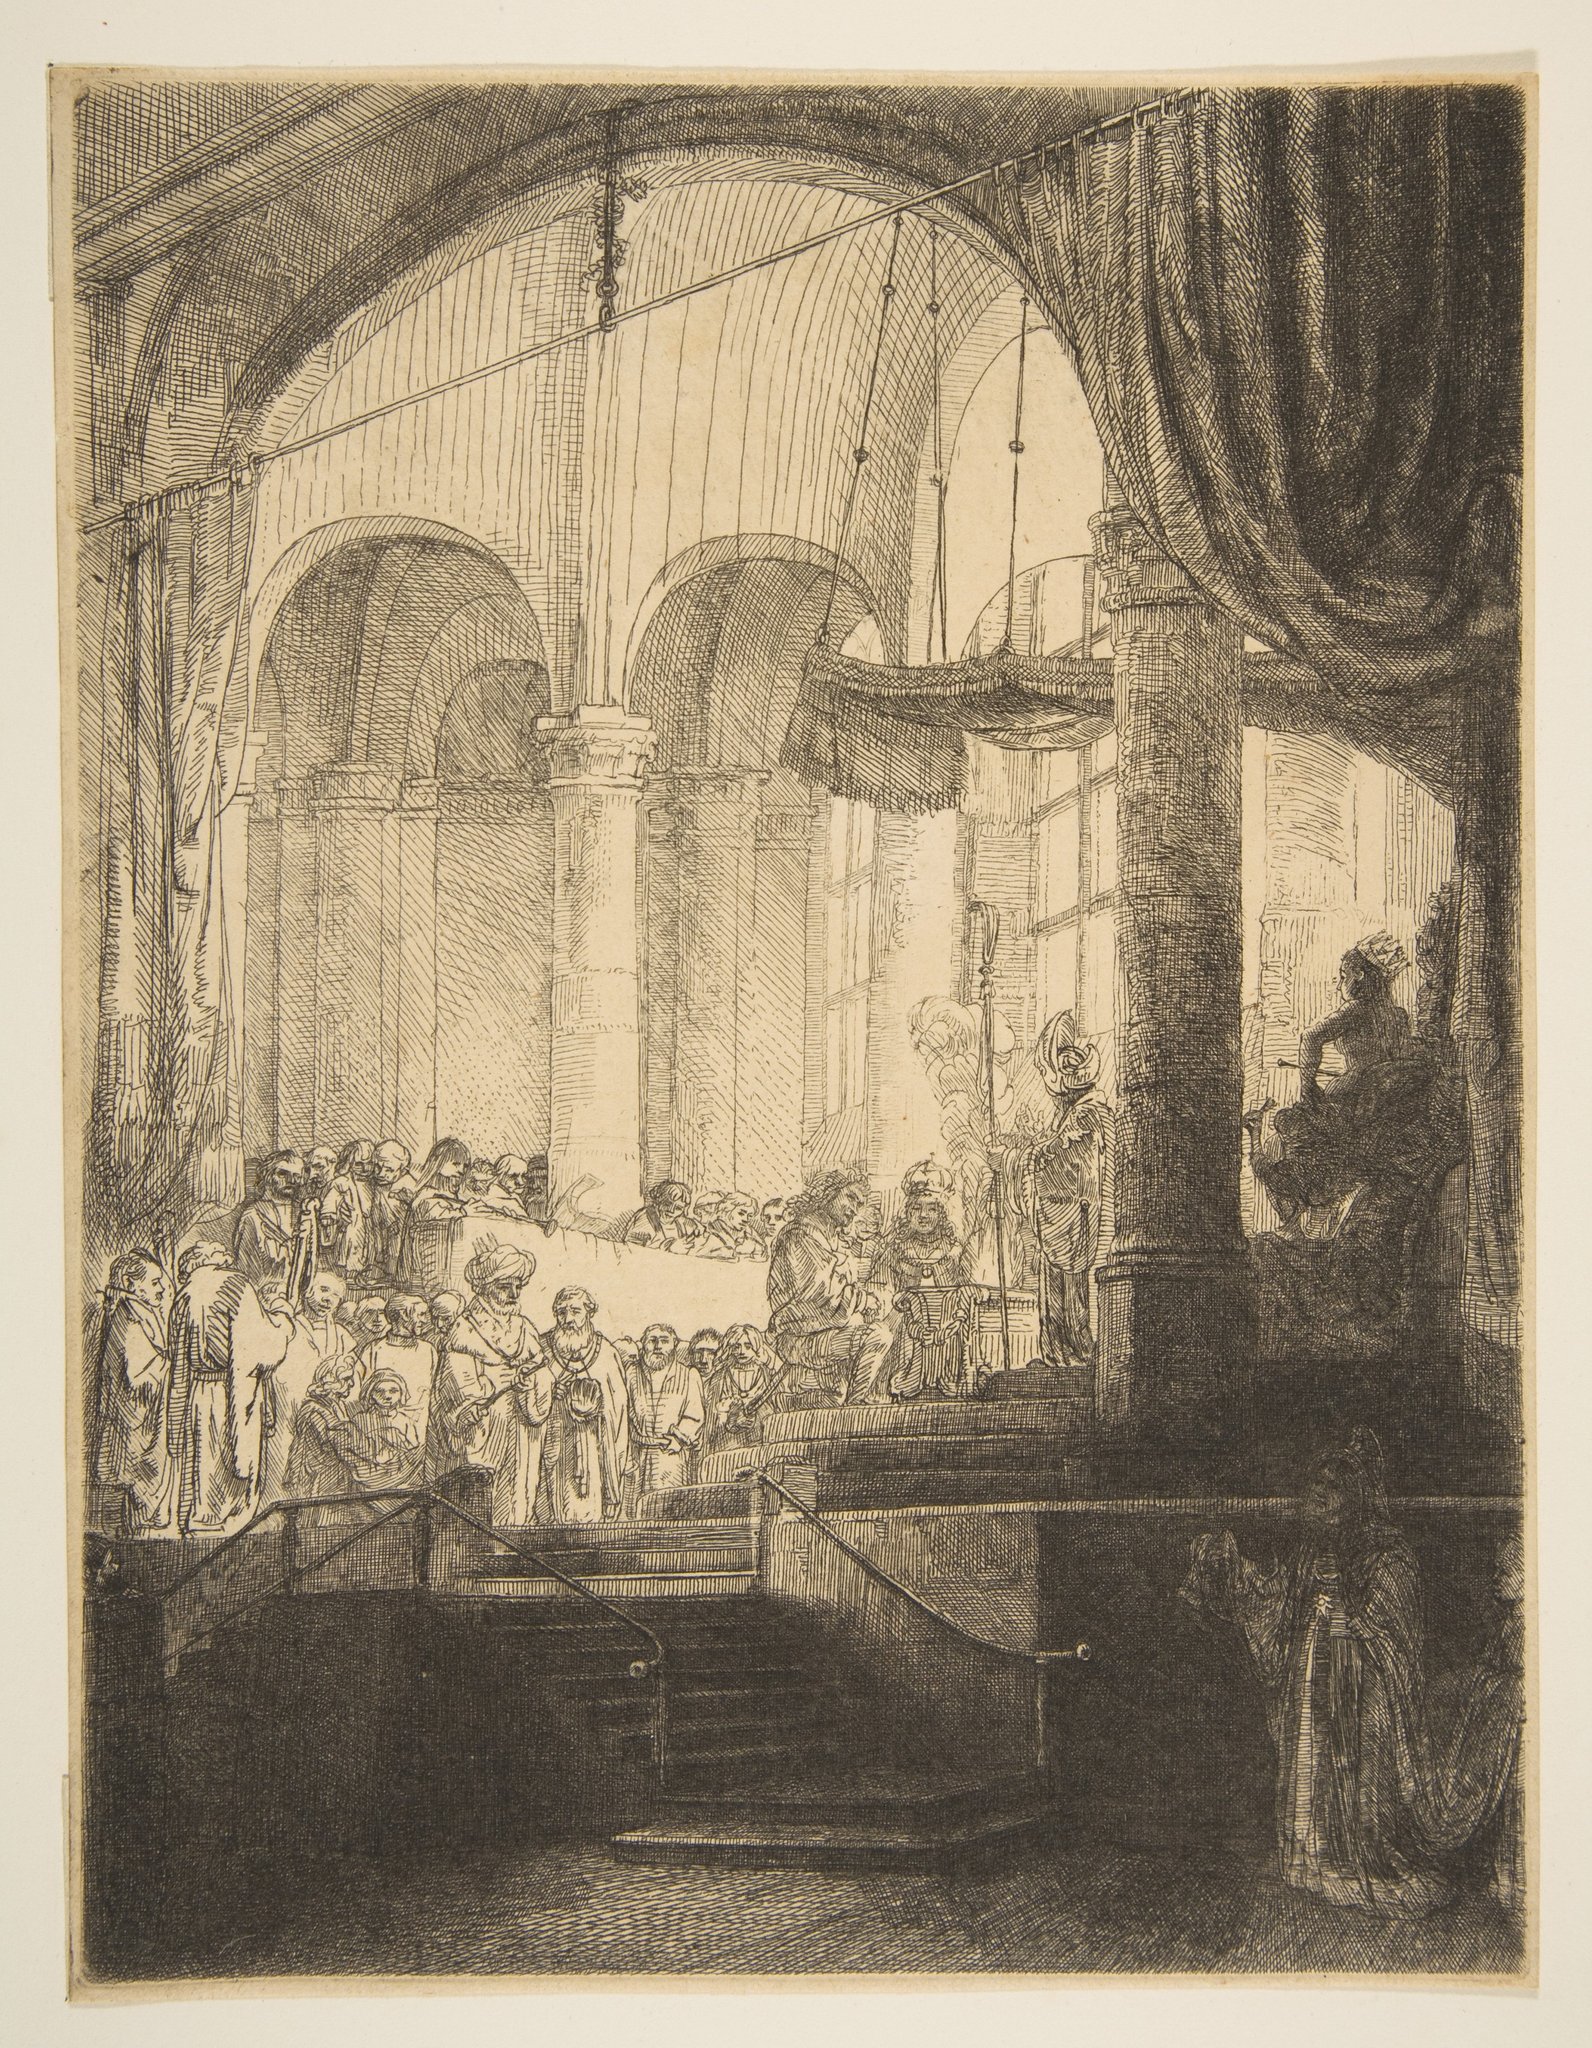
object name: print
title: Medea: or The Marriage of Jason and Creusa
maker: rembrandt van rijn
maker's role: artist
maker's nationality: dutch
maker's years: 1606-1669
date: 1648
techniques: drypoint, etching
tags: jason,crowd